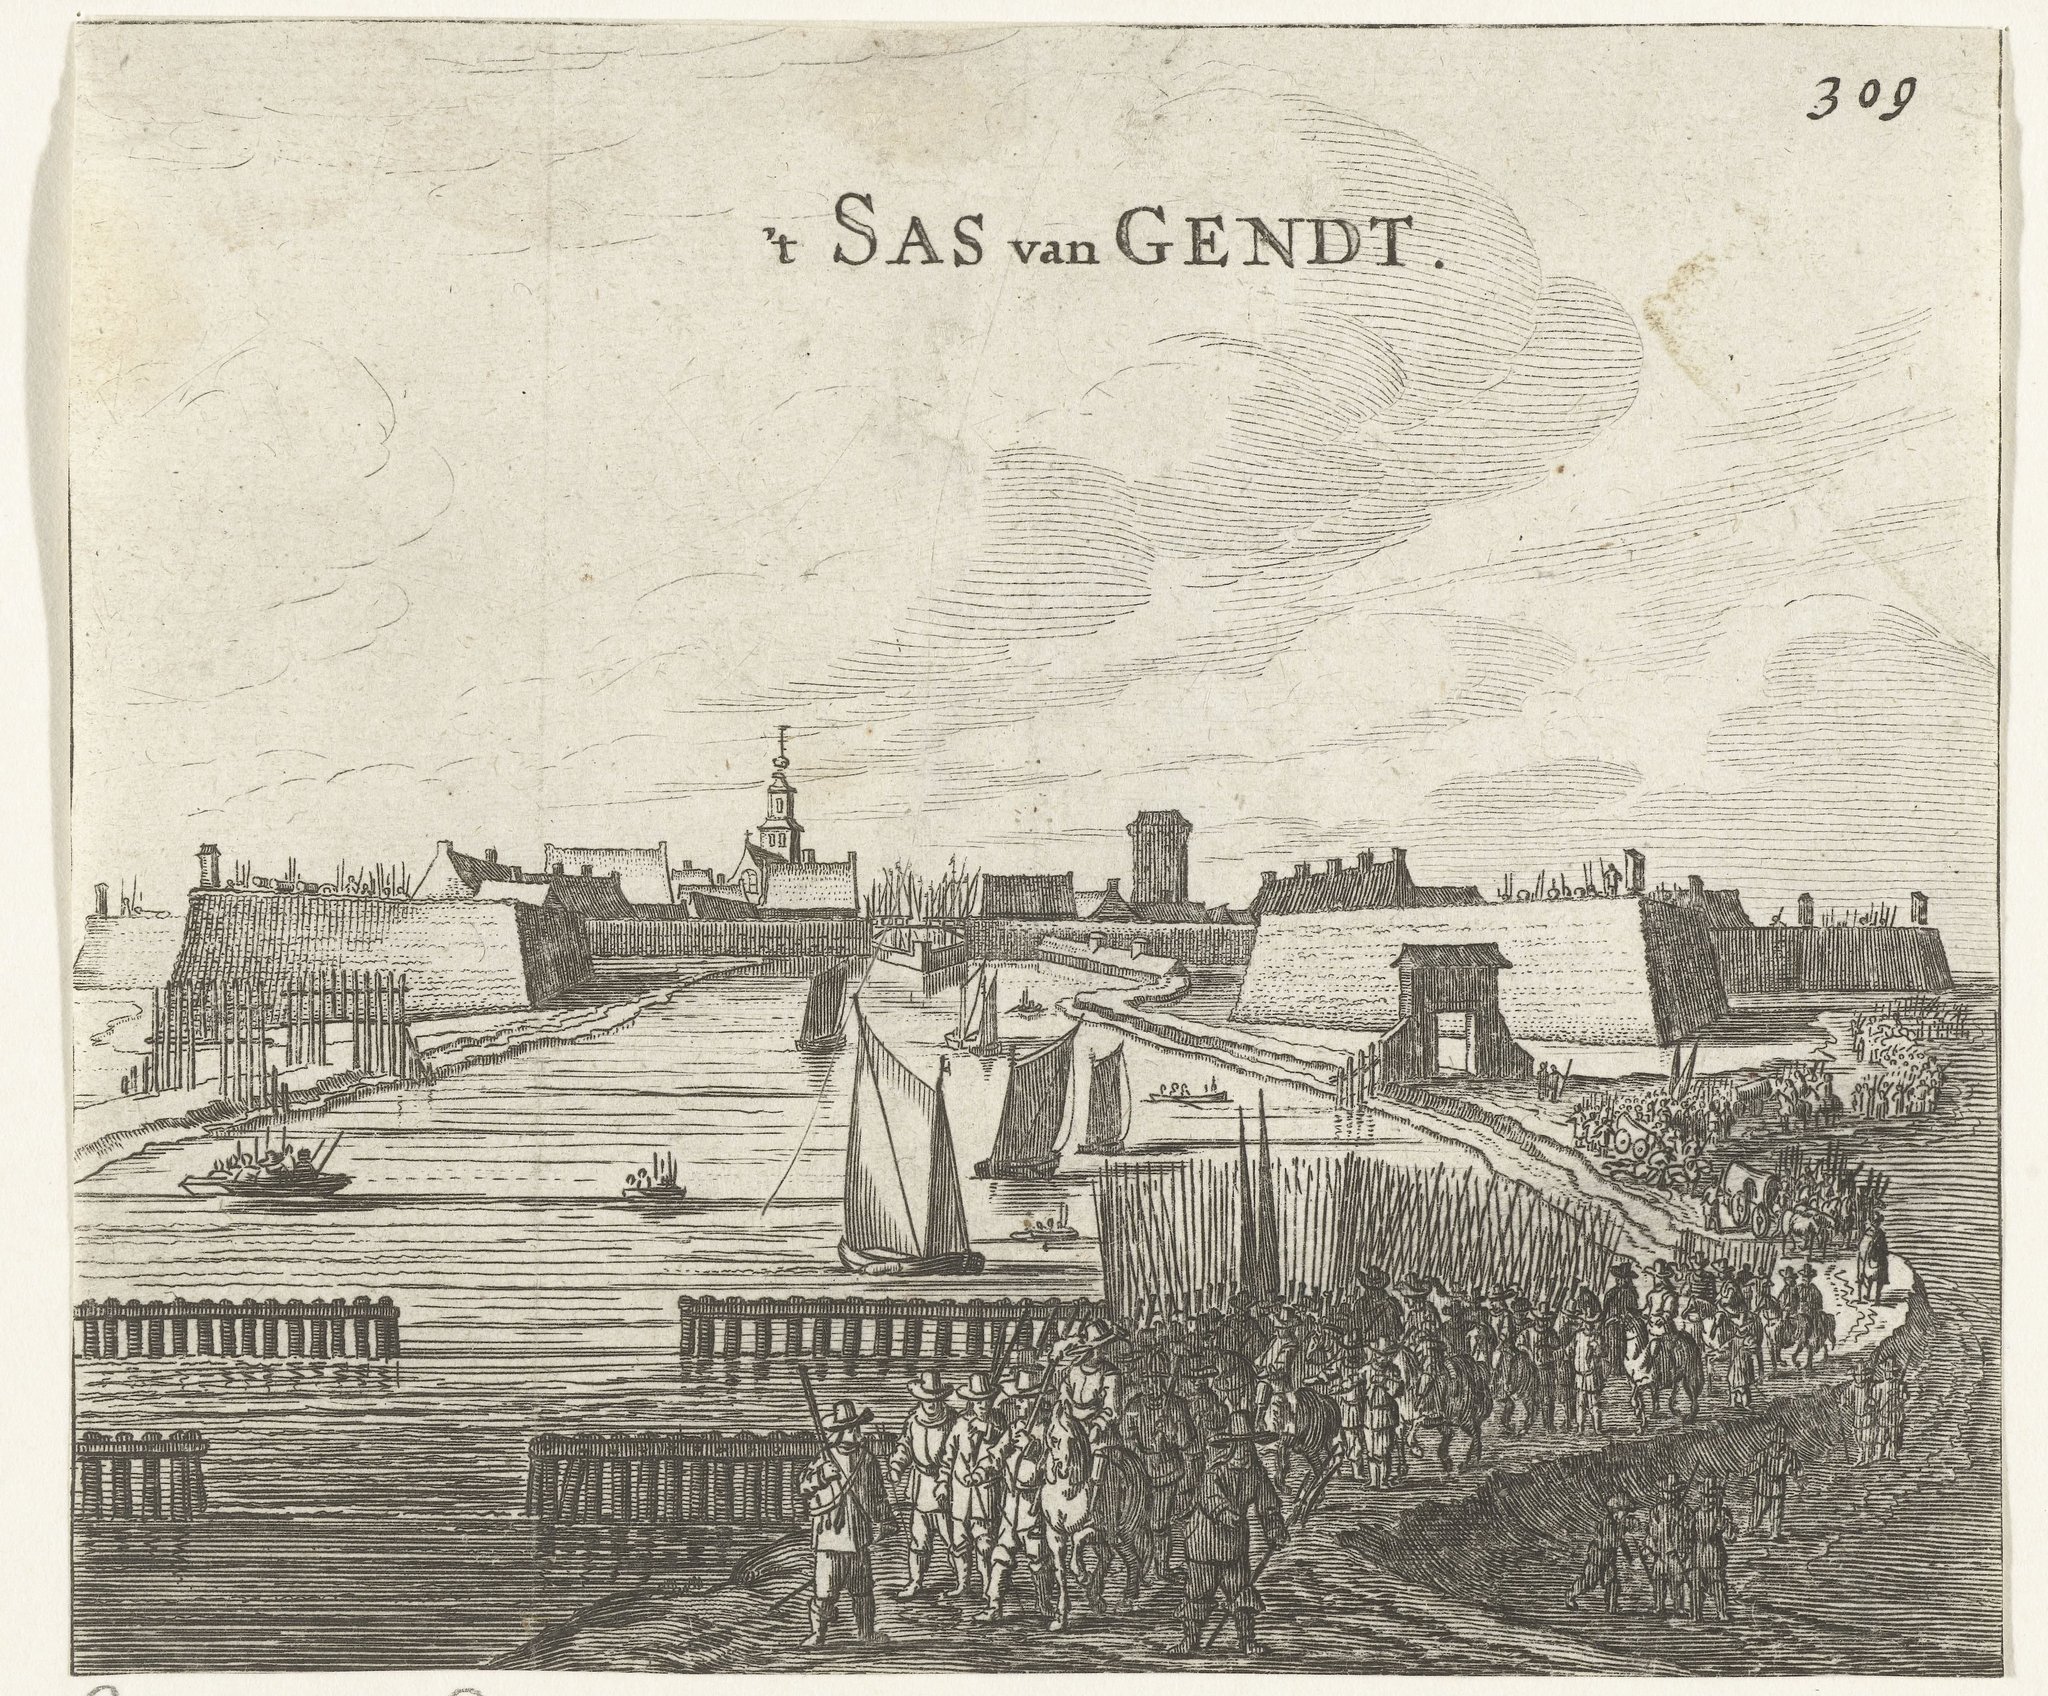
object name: history print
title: 't Sas van Gendt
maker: Anonymous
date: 1662-1664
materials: paper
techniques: etching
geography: northern netherlands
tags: delft, frederick henry (prince of orange), siege, position war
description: Gebruikt als illustratie in: A. Montanus, 't Leven en bedryf der Prinsen van Oranie : Wilhem de eerste, Maurits, Frederik Henrik, Wilhem de tweede, Wilhem de derde, Arent van den Heuvel, en Samuel Imbrechts, Amsterdam, 1664, p. 309. Kopie naar de prent in A. Montanus, 'T leven en bedryf van Frederik Henrik, J. Hartgers, Amsterdam 1652.